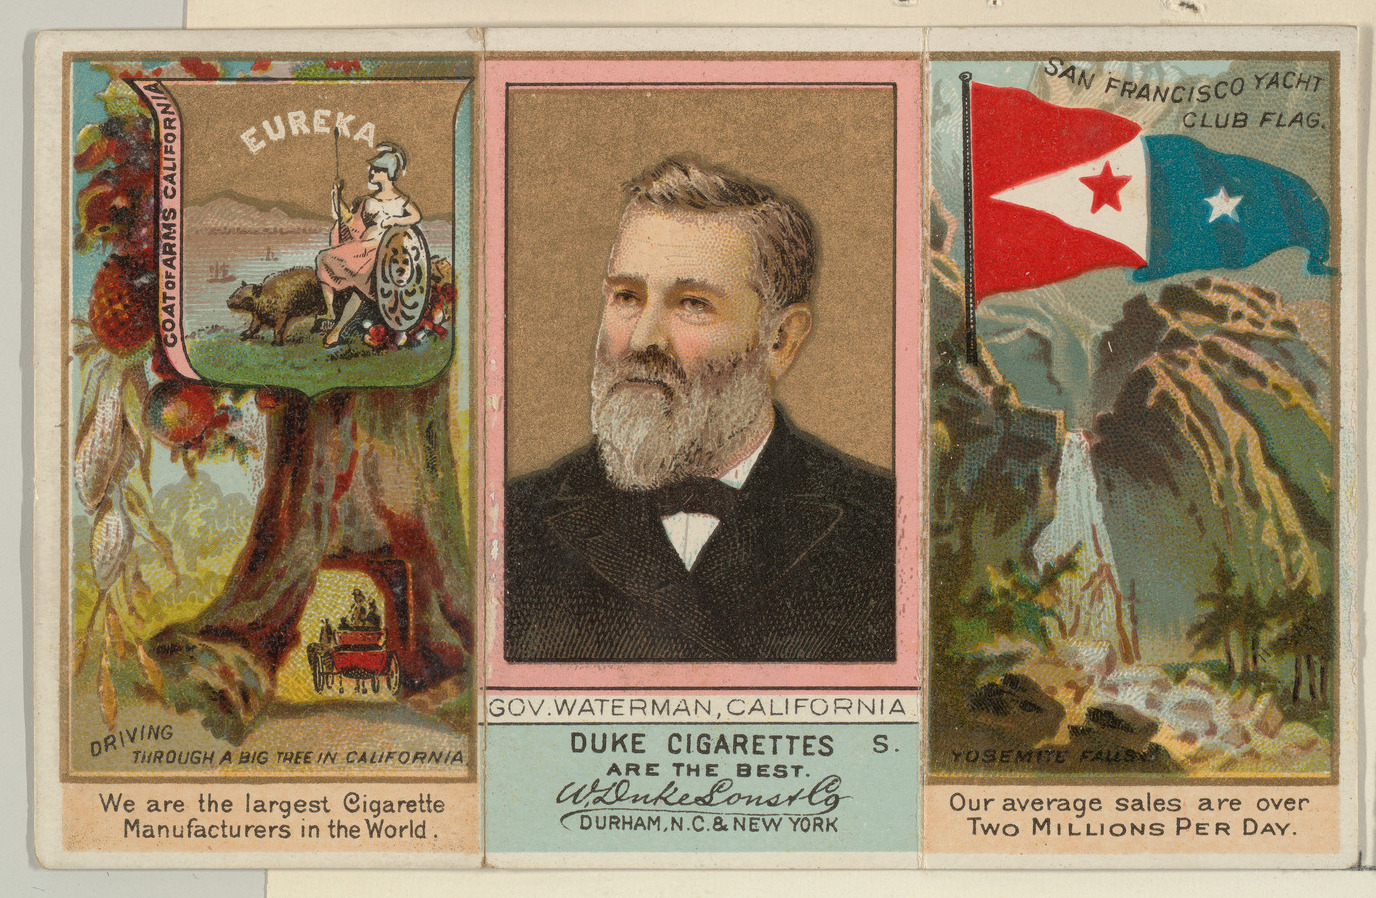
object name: print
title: Governor Waterman, California, from "Governors, Arms, Etc." series (N133-2), issued by Duke Sons & Co.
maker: w. duke, sons & co.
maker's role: publisher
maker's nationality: american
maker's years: 1870-1920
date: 1888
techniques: color lithograph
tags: men,portraits,coat of arms,flags